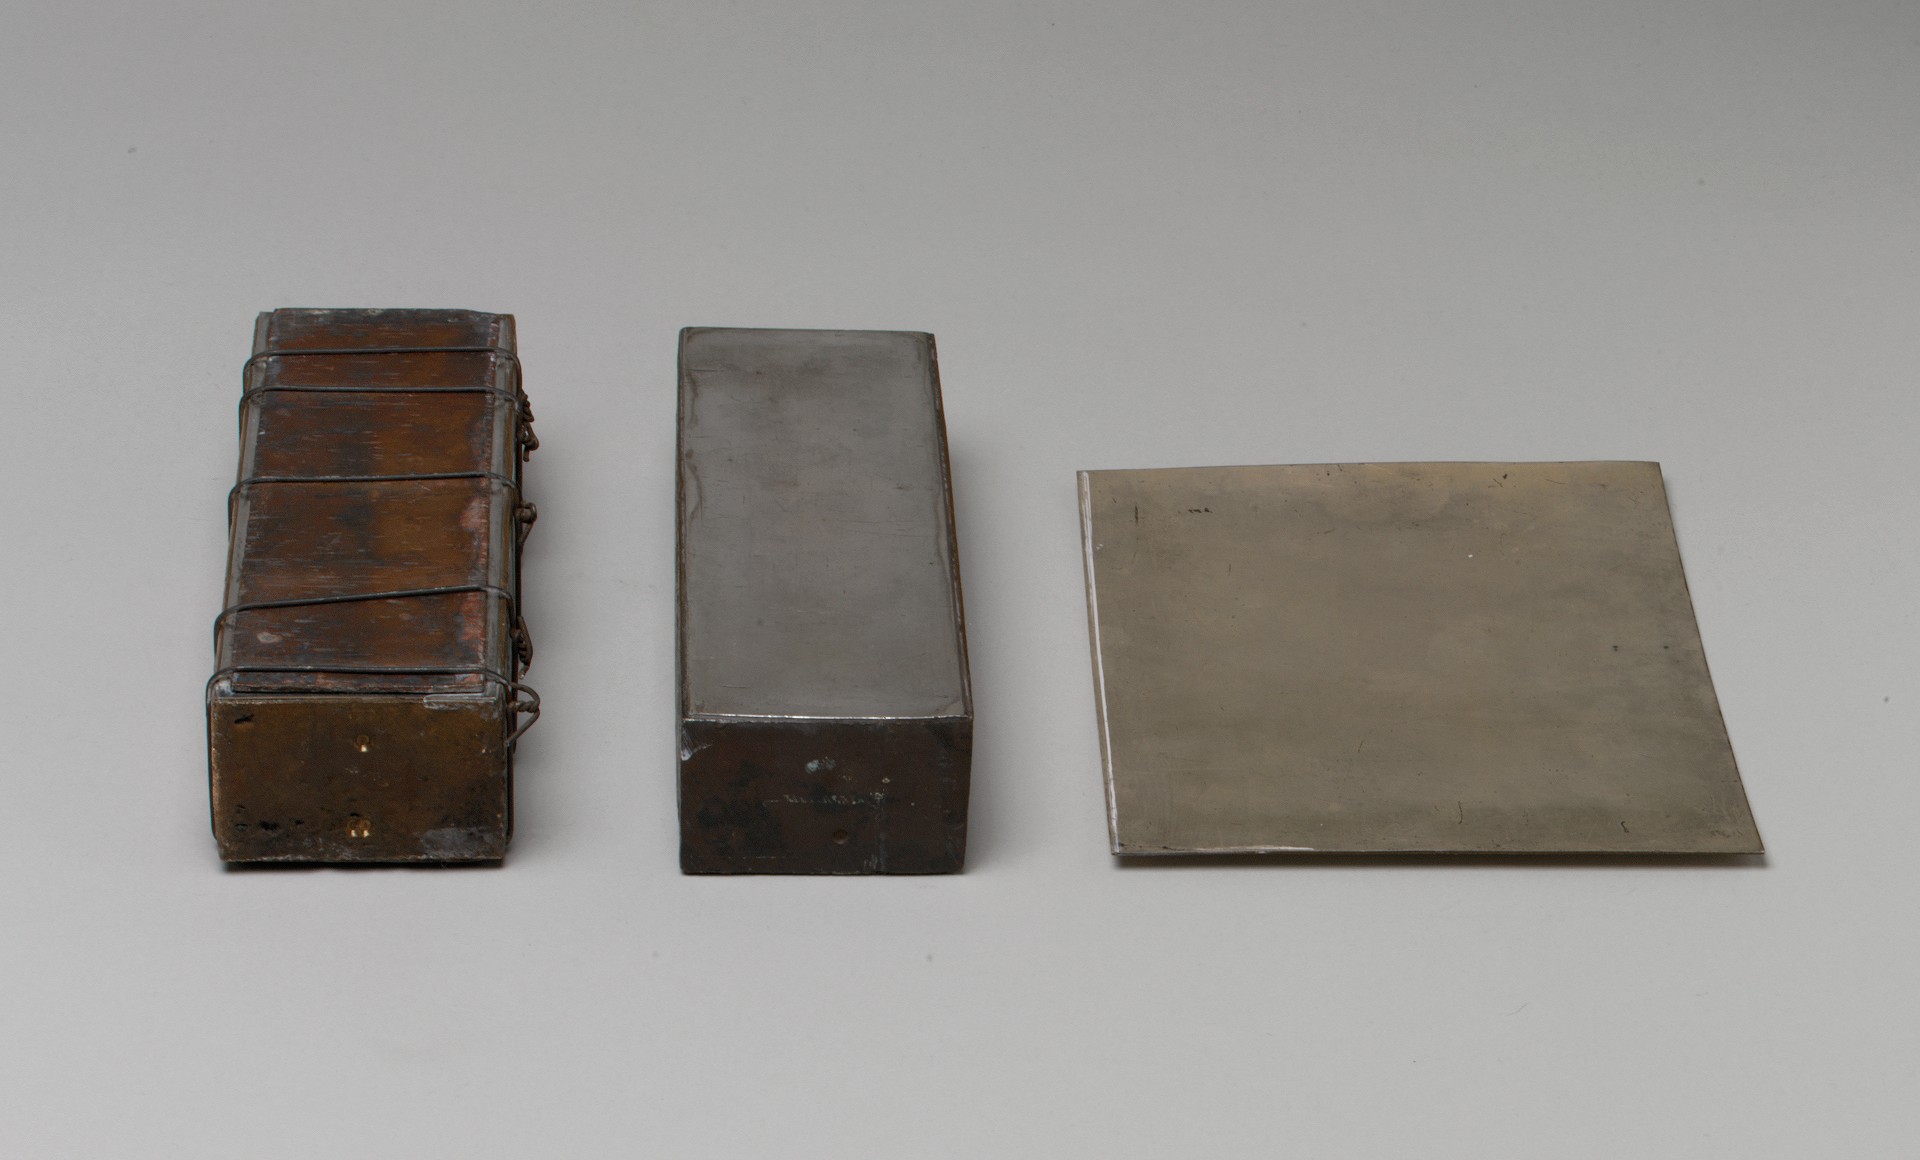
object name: ingot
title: Two ingots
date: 1801-1900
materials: metal